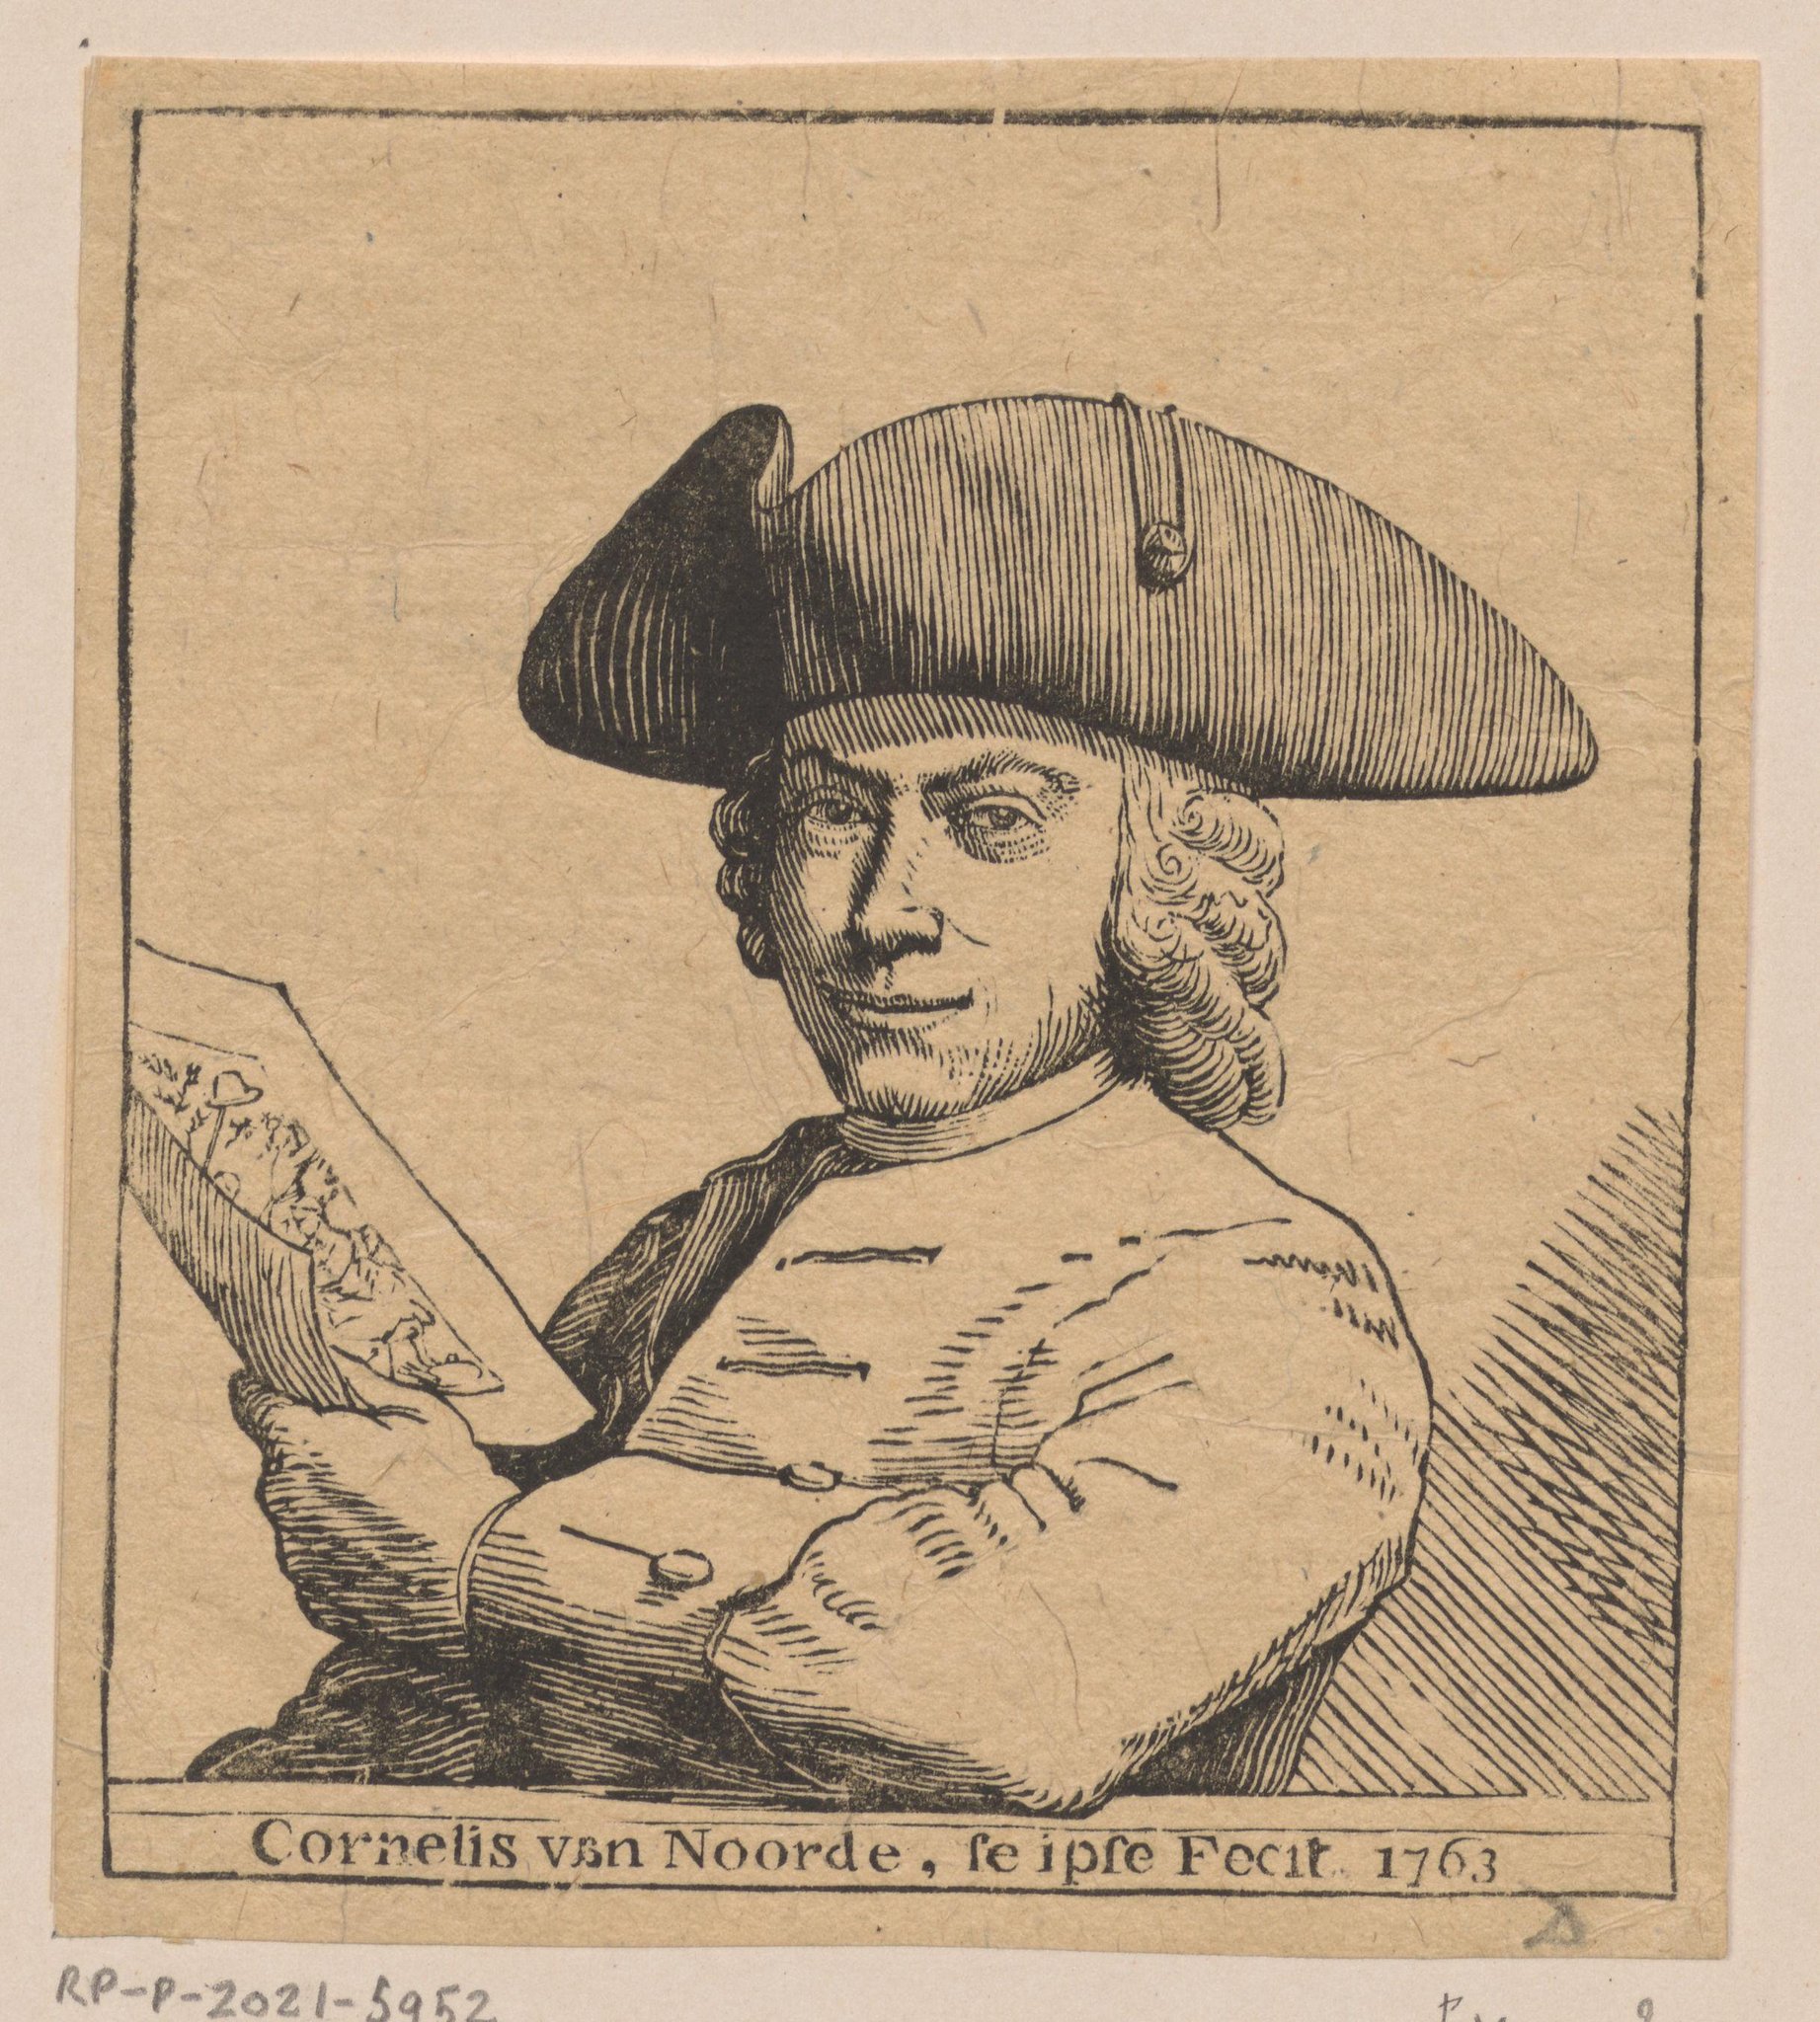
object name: print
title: Zelfportret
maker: cornelis van noorde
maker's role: draughtsman, print maker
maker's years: 1731-1795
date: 1763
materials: paper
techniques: woodcut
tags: haarlem, print maker, draughtsman, cornelis van noorde, historical persons, graphic artist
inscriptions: collector's mark: Lugt 240